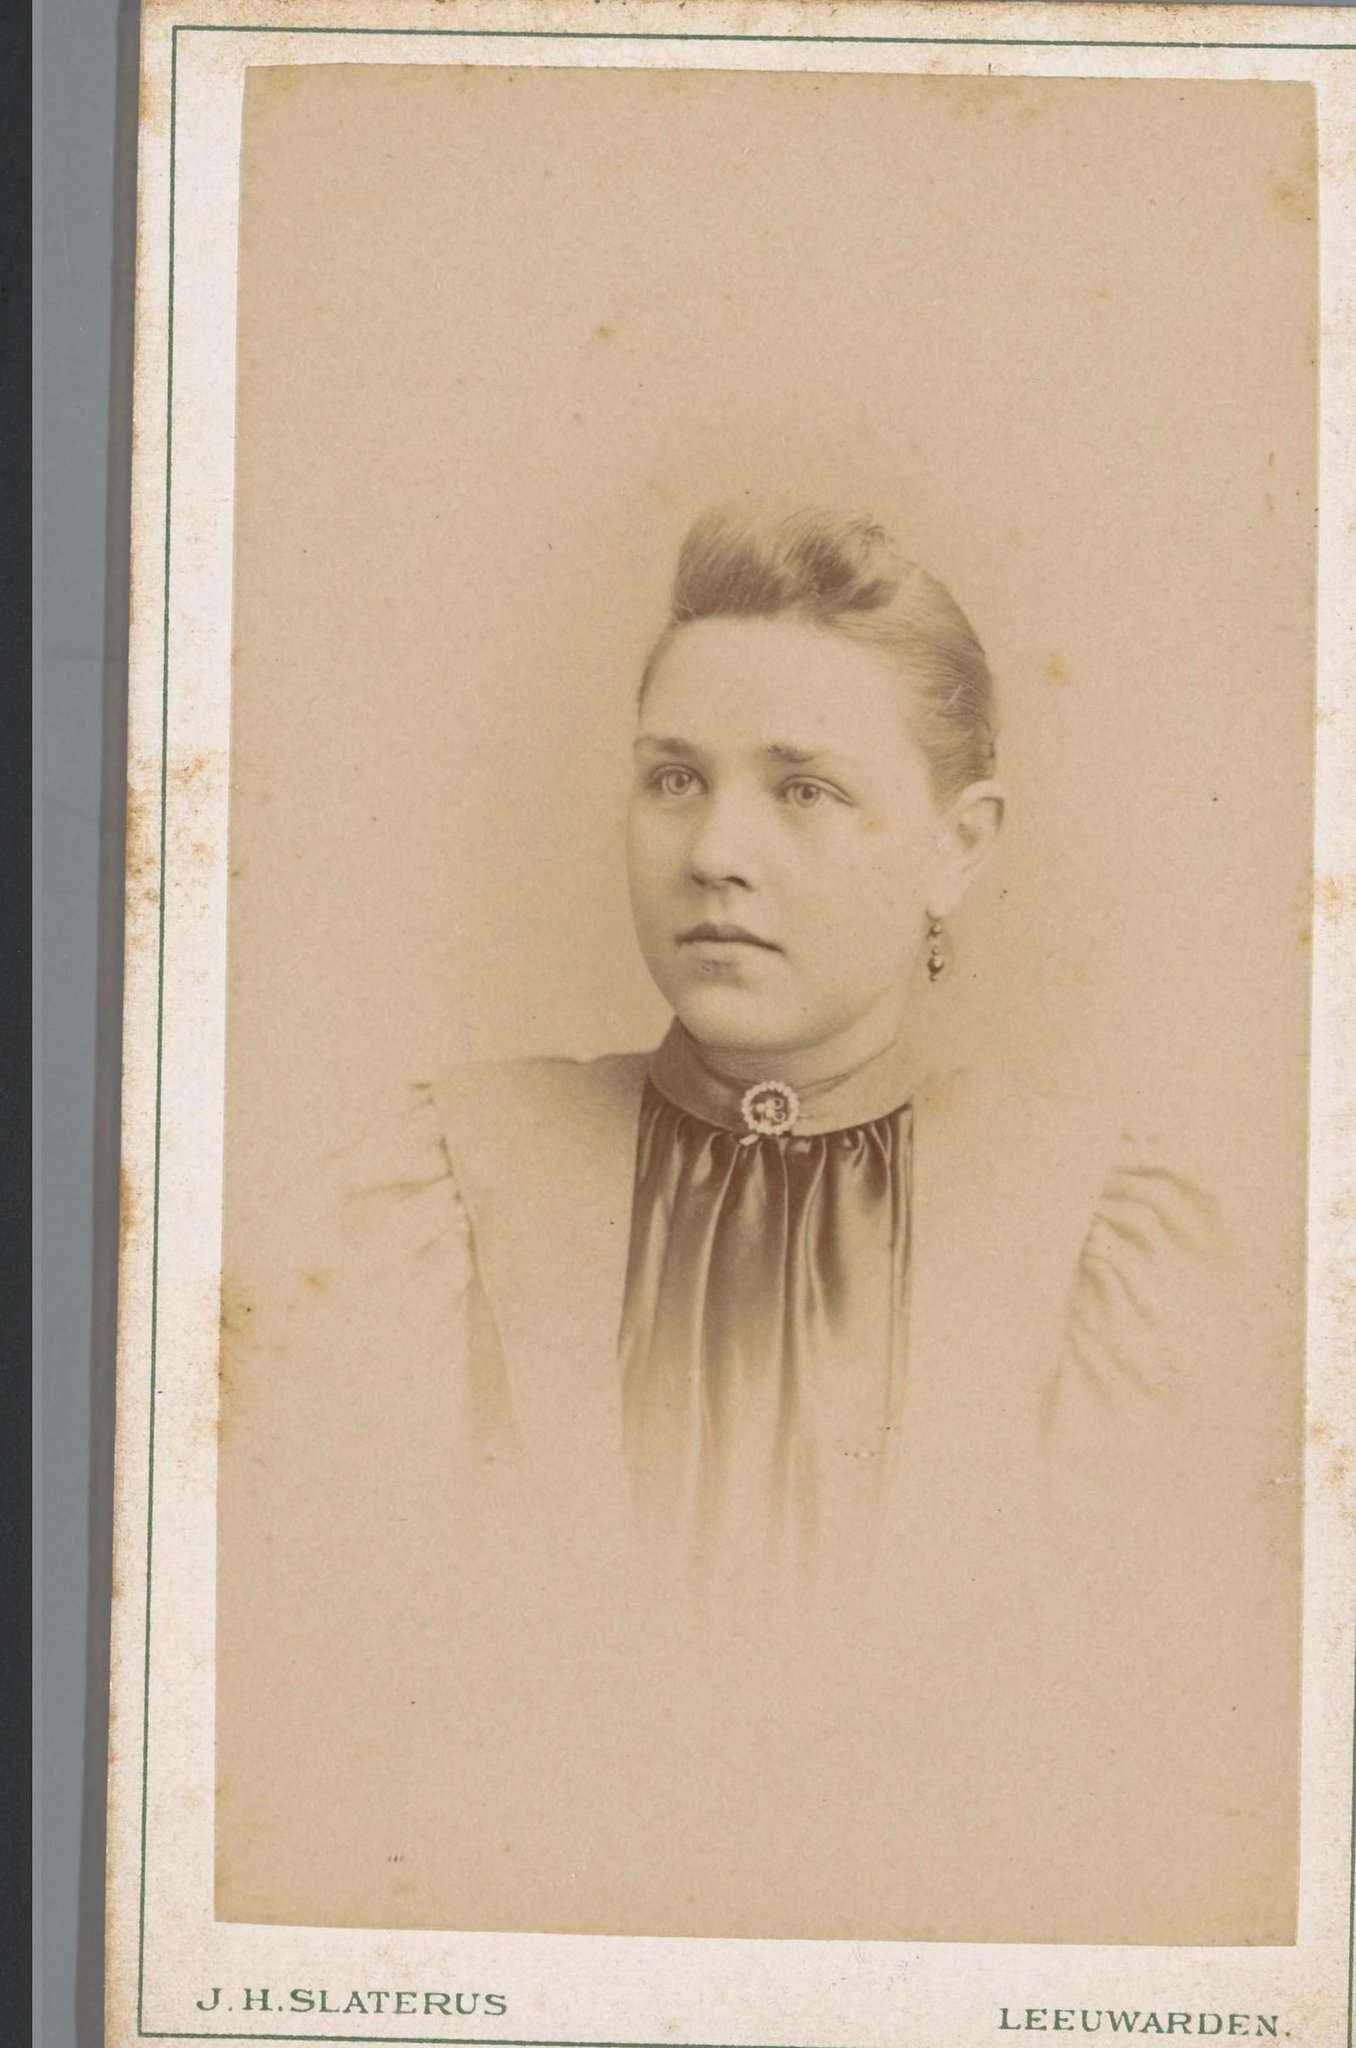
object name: photograph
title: Portret van een onbekende vrouw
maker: idanus hendrikus slaterus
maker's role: fotograaf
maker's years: 1846-1921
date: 1892-1909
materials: cardboard, paper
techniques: albumen print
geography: leeuwarden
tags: historical persons - bb - woman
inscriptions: inscription: ‘Photographie Instantanée/ J. H. SLATERUS/ Langemarktstraat/ tegenover het Station bij de/ nieuwe Veemarkt/ Let. W. No. 14./ LEEUWARDEN.’, inscription: ‘Renske?’